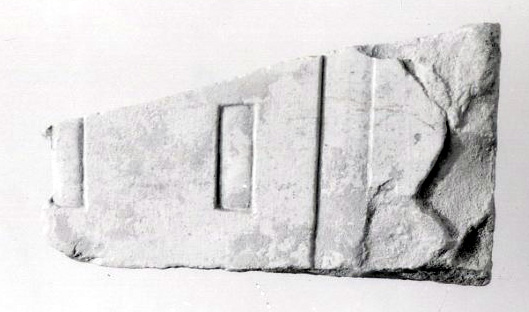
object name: relief fragment, tomb of meketre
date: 1981-1975 BCE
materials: limestone, paint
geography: egypt